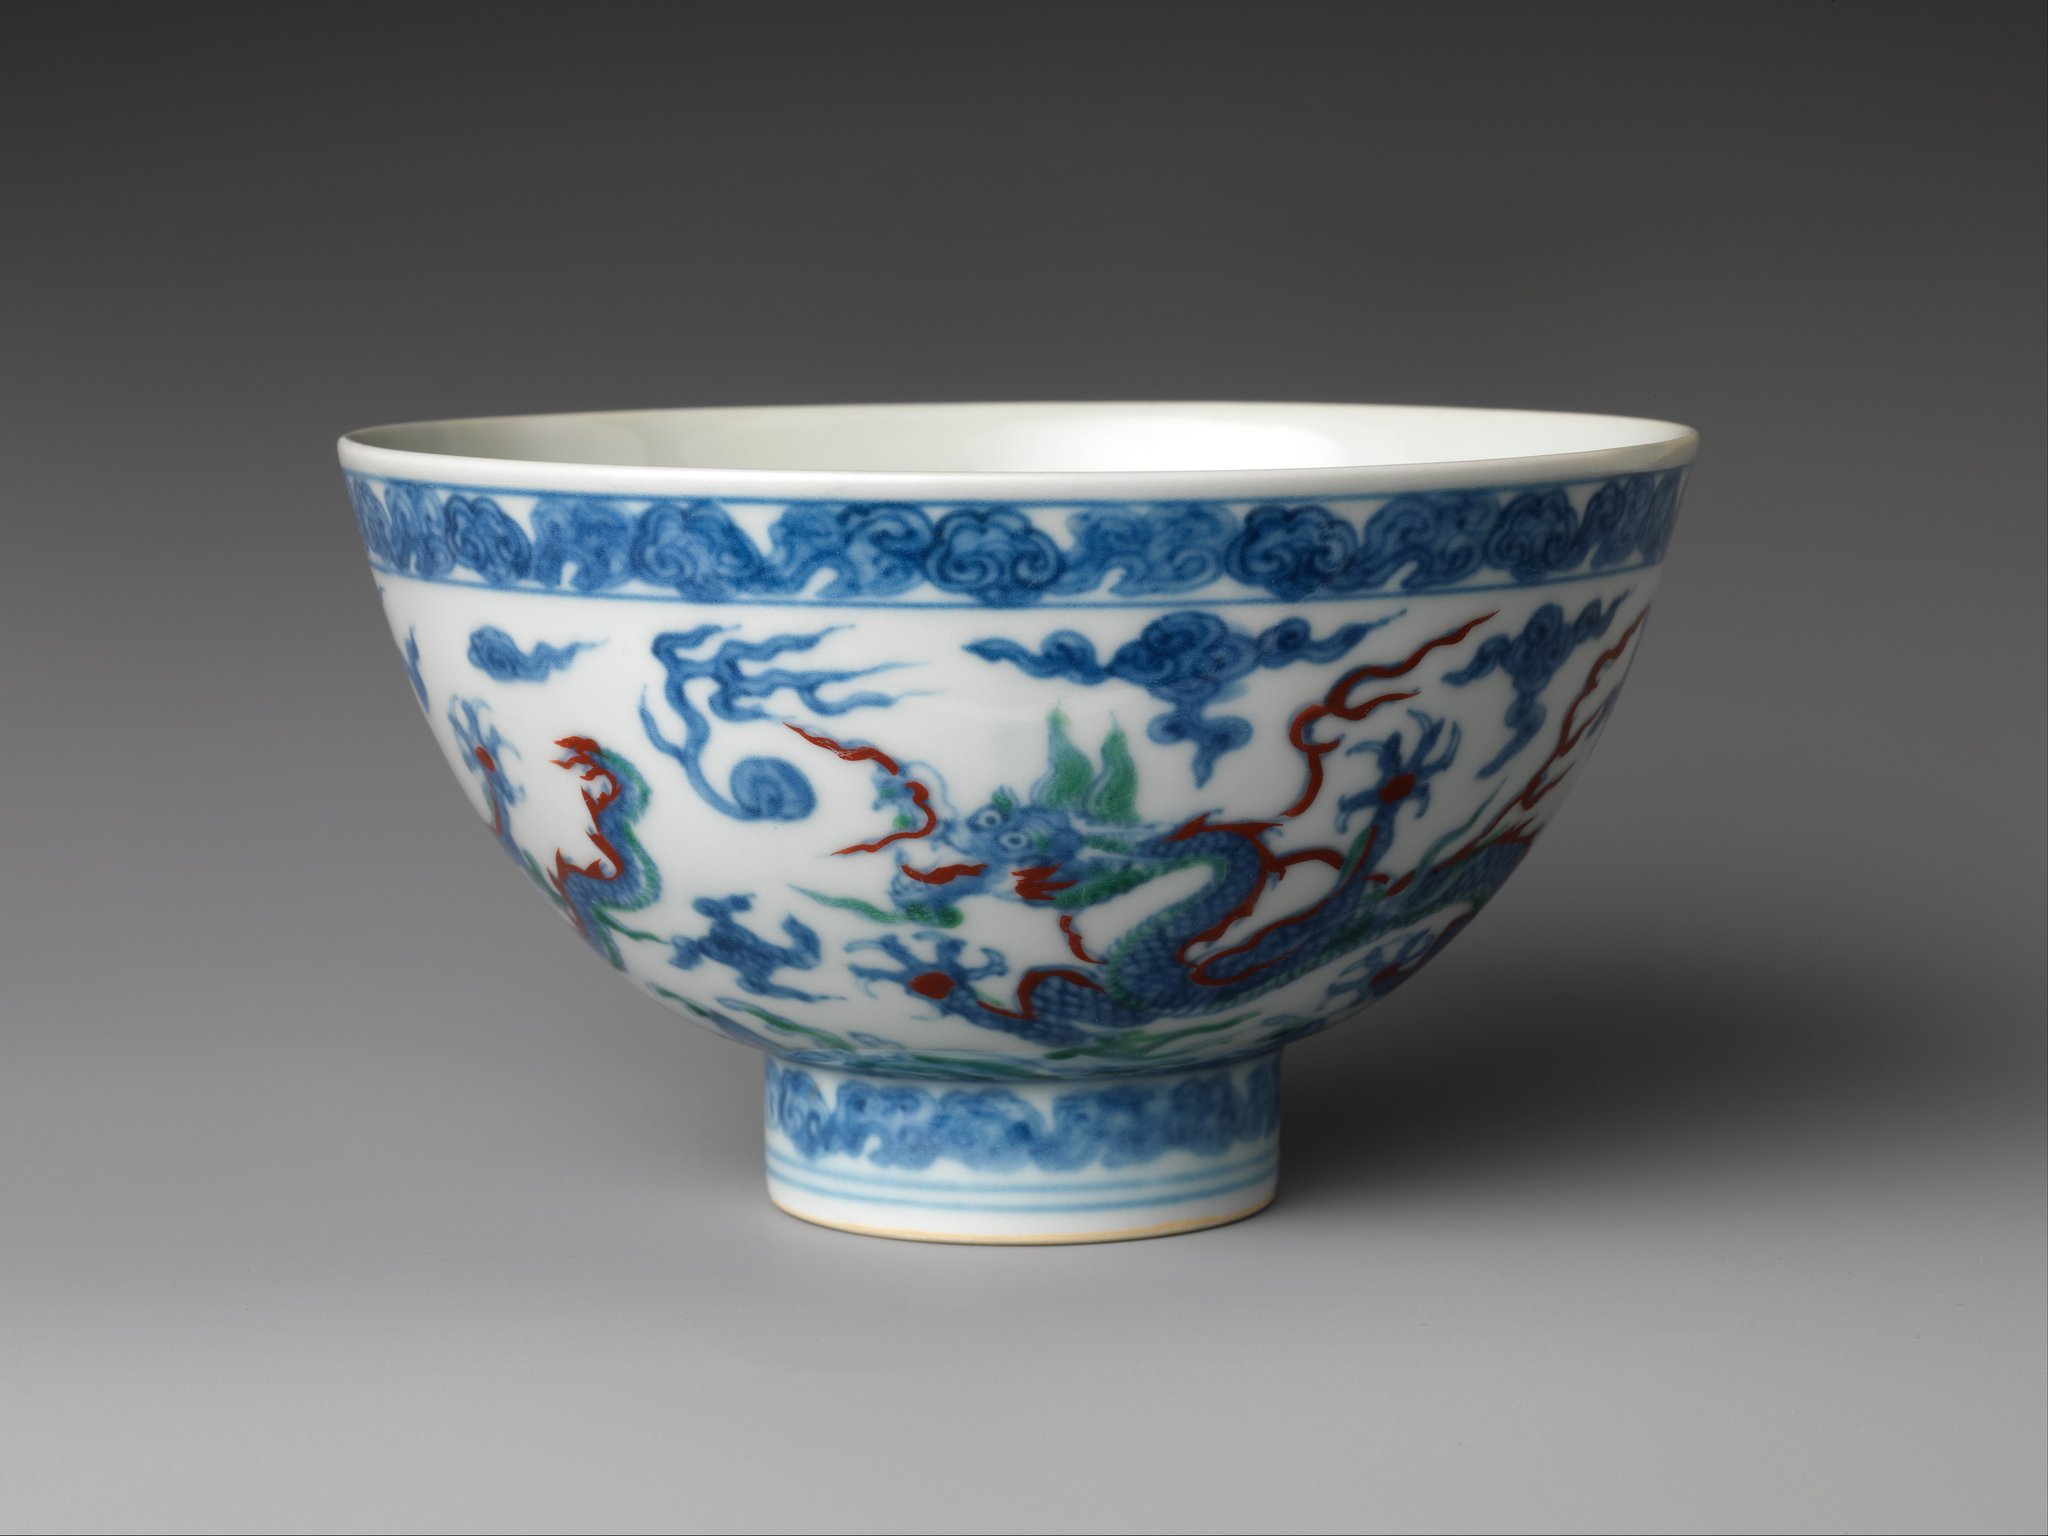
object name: bowl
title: Bowl with dragons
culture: chinese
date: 1506-1521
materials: cobalt, enamel, porcelain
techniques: overglaze, painting, underglaze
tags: dragons